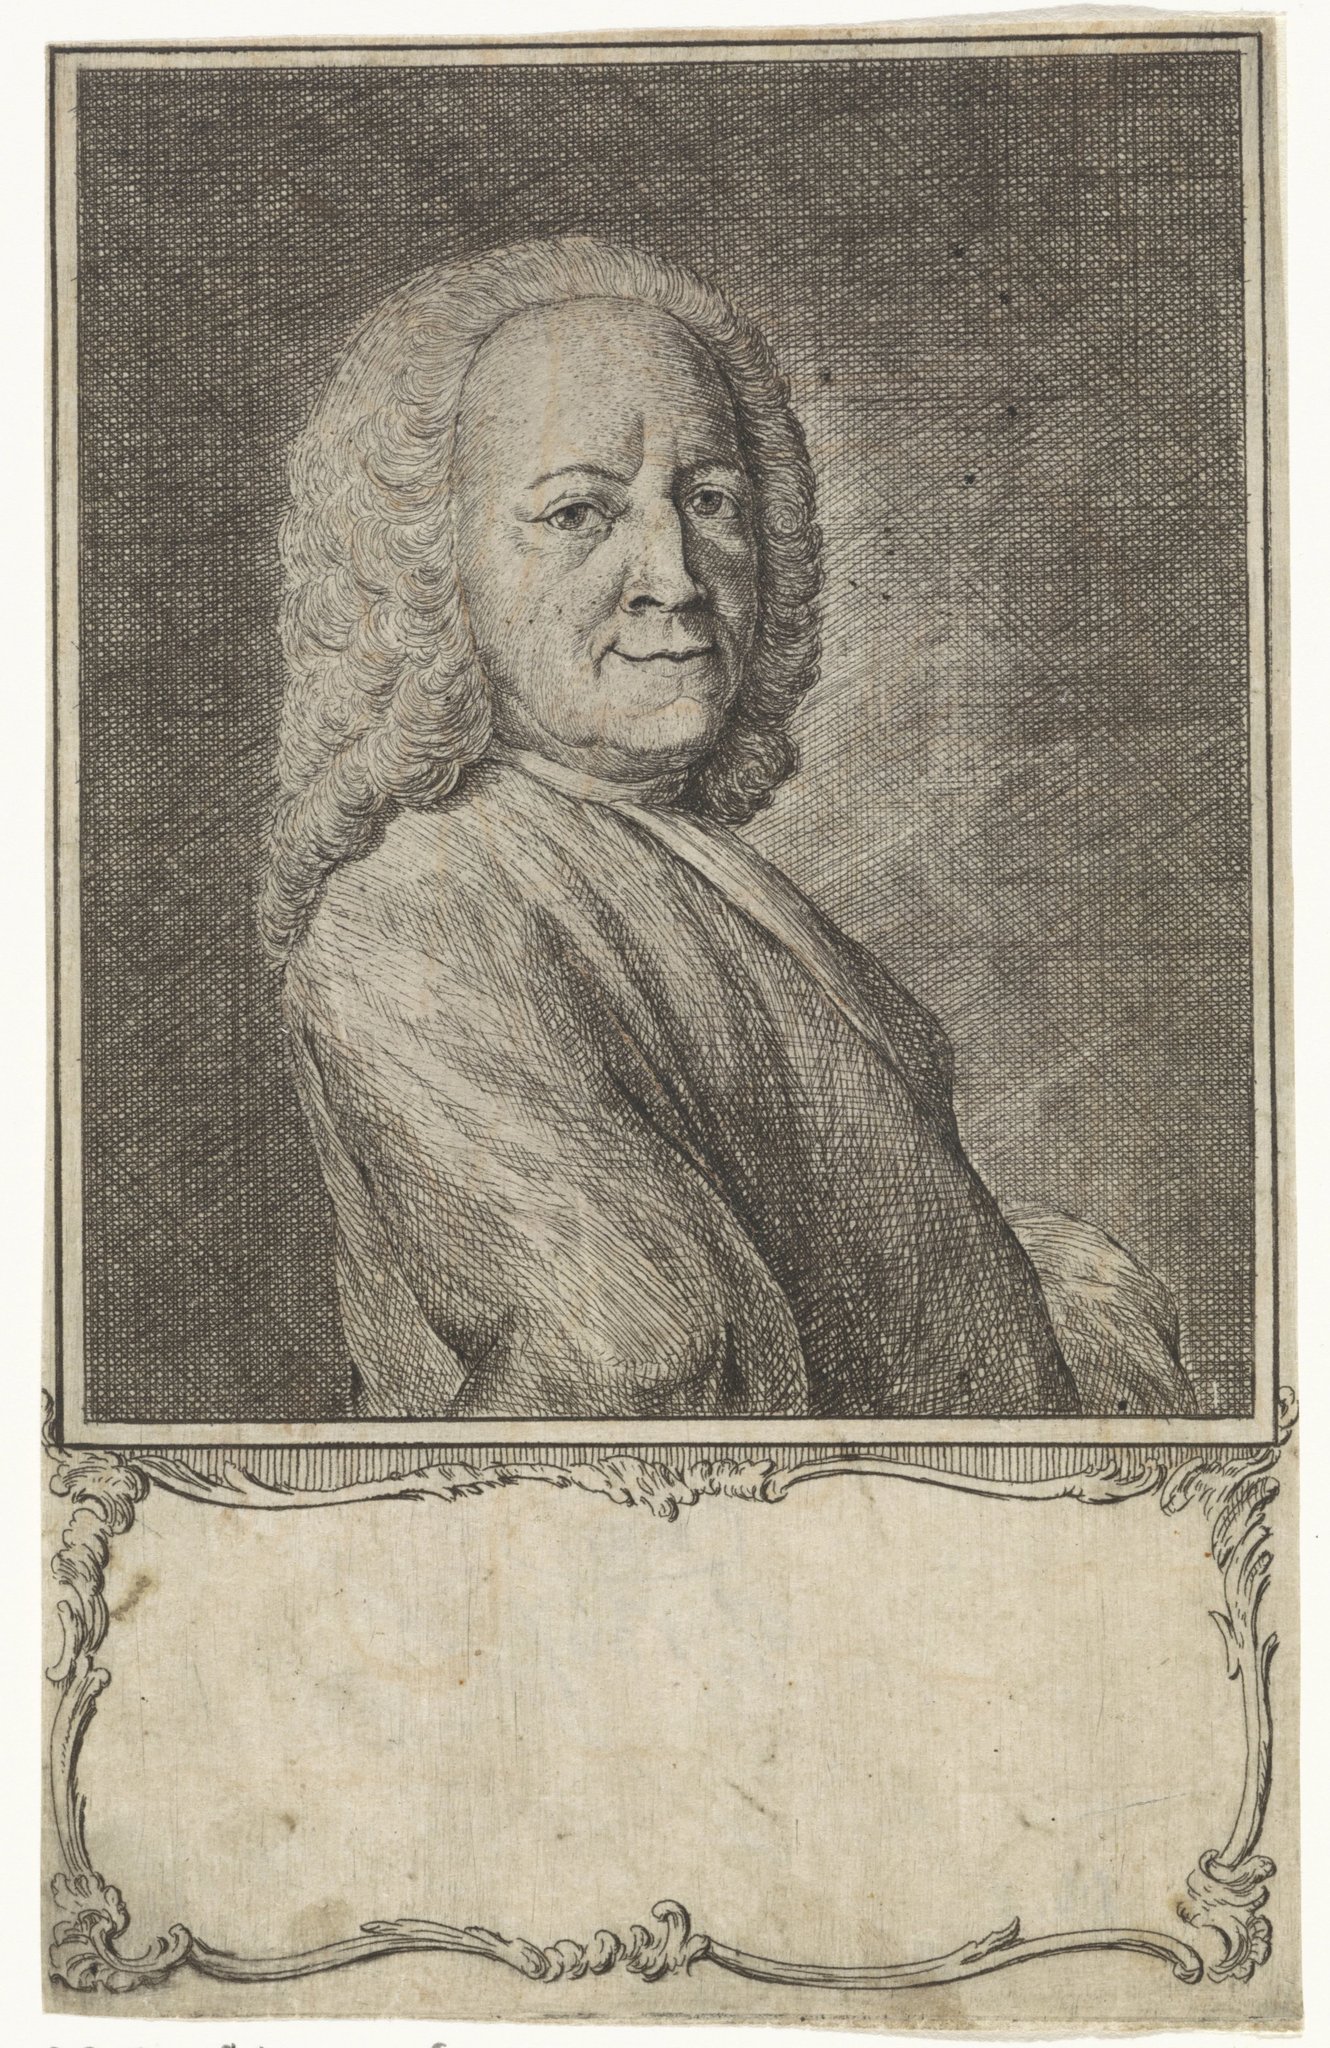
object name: print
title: Portret van Johannes Buma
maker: rienk jelgerhuis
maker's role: draughtsman, print maker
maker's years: 1729-1806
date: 1767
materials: paper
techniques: etching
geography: leeuwarden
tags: wig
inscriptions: collector's mark: Lugt 2228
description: De schilder en dichter Johannes Buma. Hij draagt een pruik.